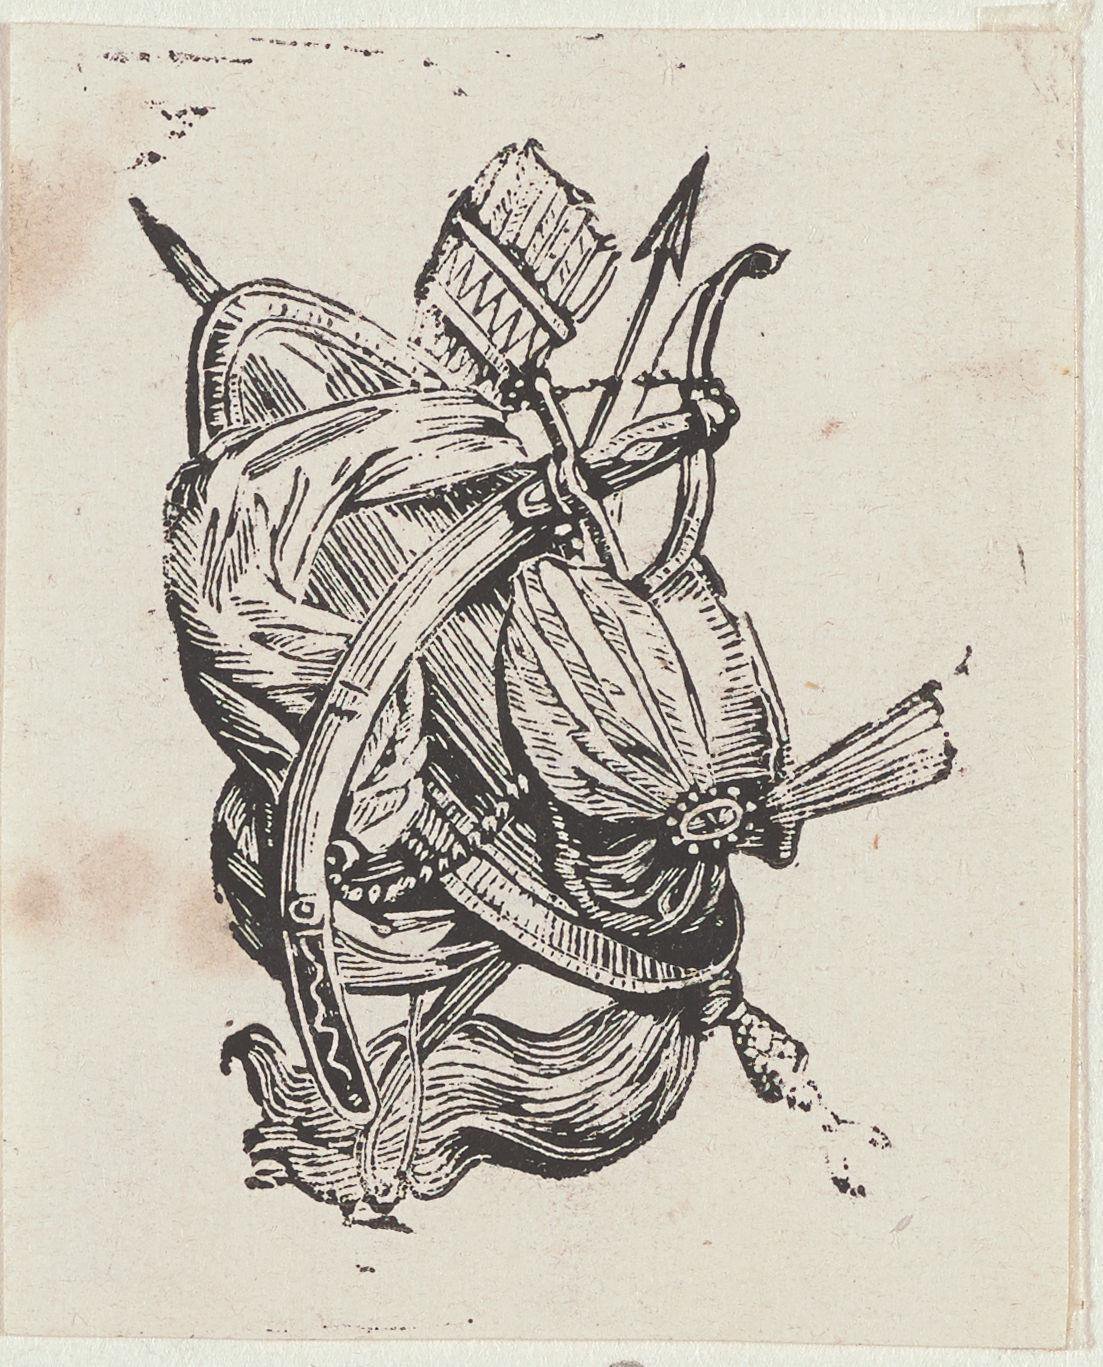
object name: print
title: Wapentuig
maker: isaac weissenbruch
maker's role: print maker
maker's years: 1826-1912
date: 1836-1912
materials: paper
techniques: engraving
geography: netherlands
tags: protective weapons: shield, archer's weapons: bow and arrow, helved weapons, polearms (for striking, hacking, thrusting): lance, weapons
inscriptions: collector's mark: Lugt 2228